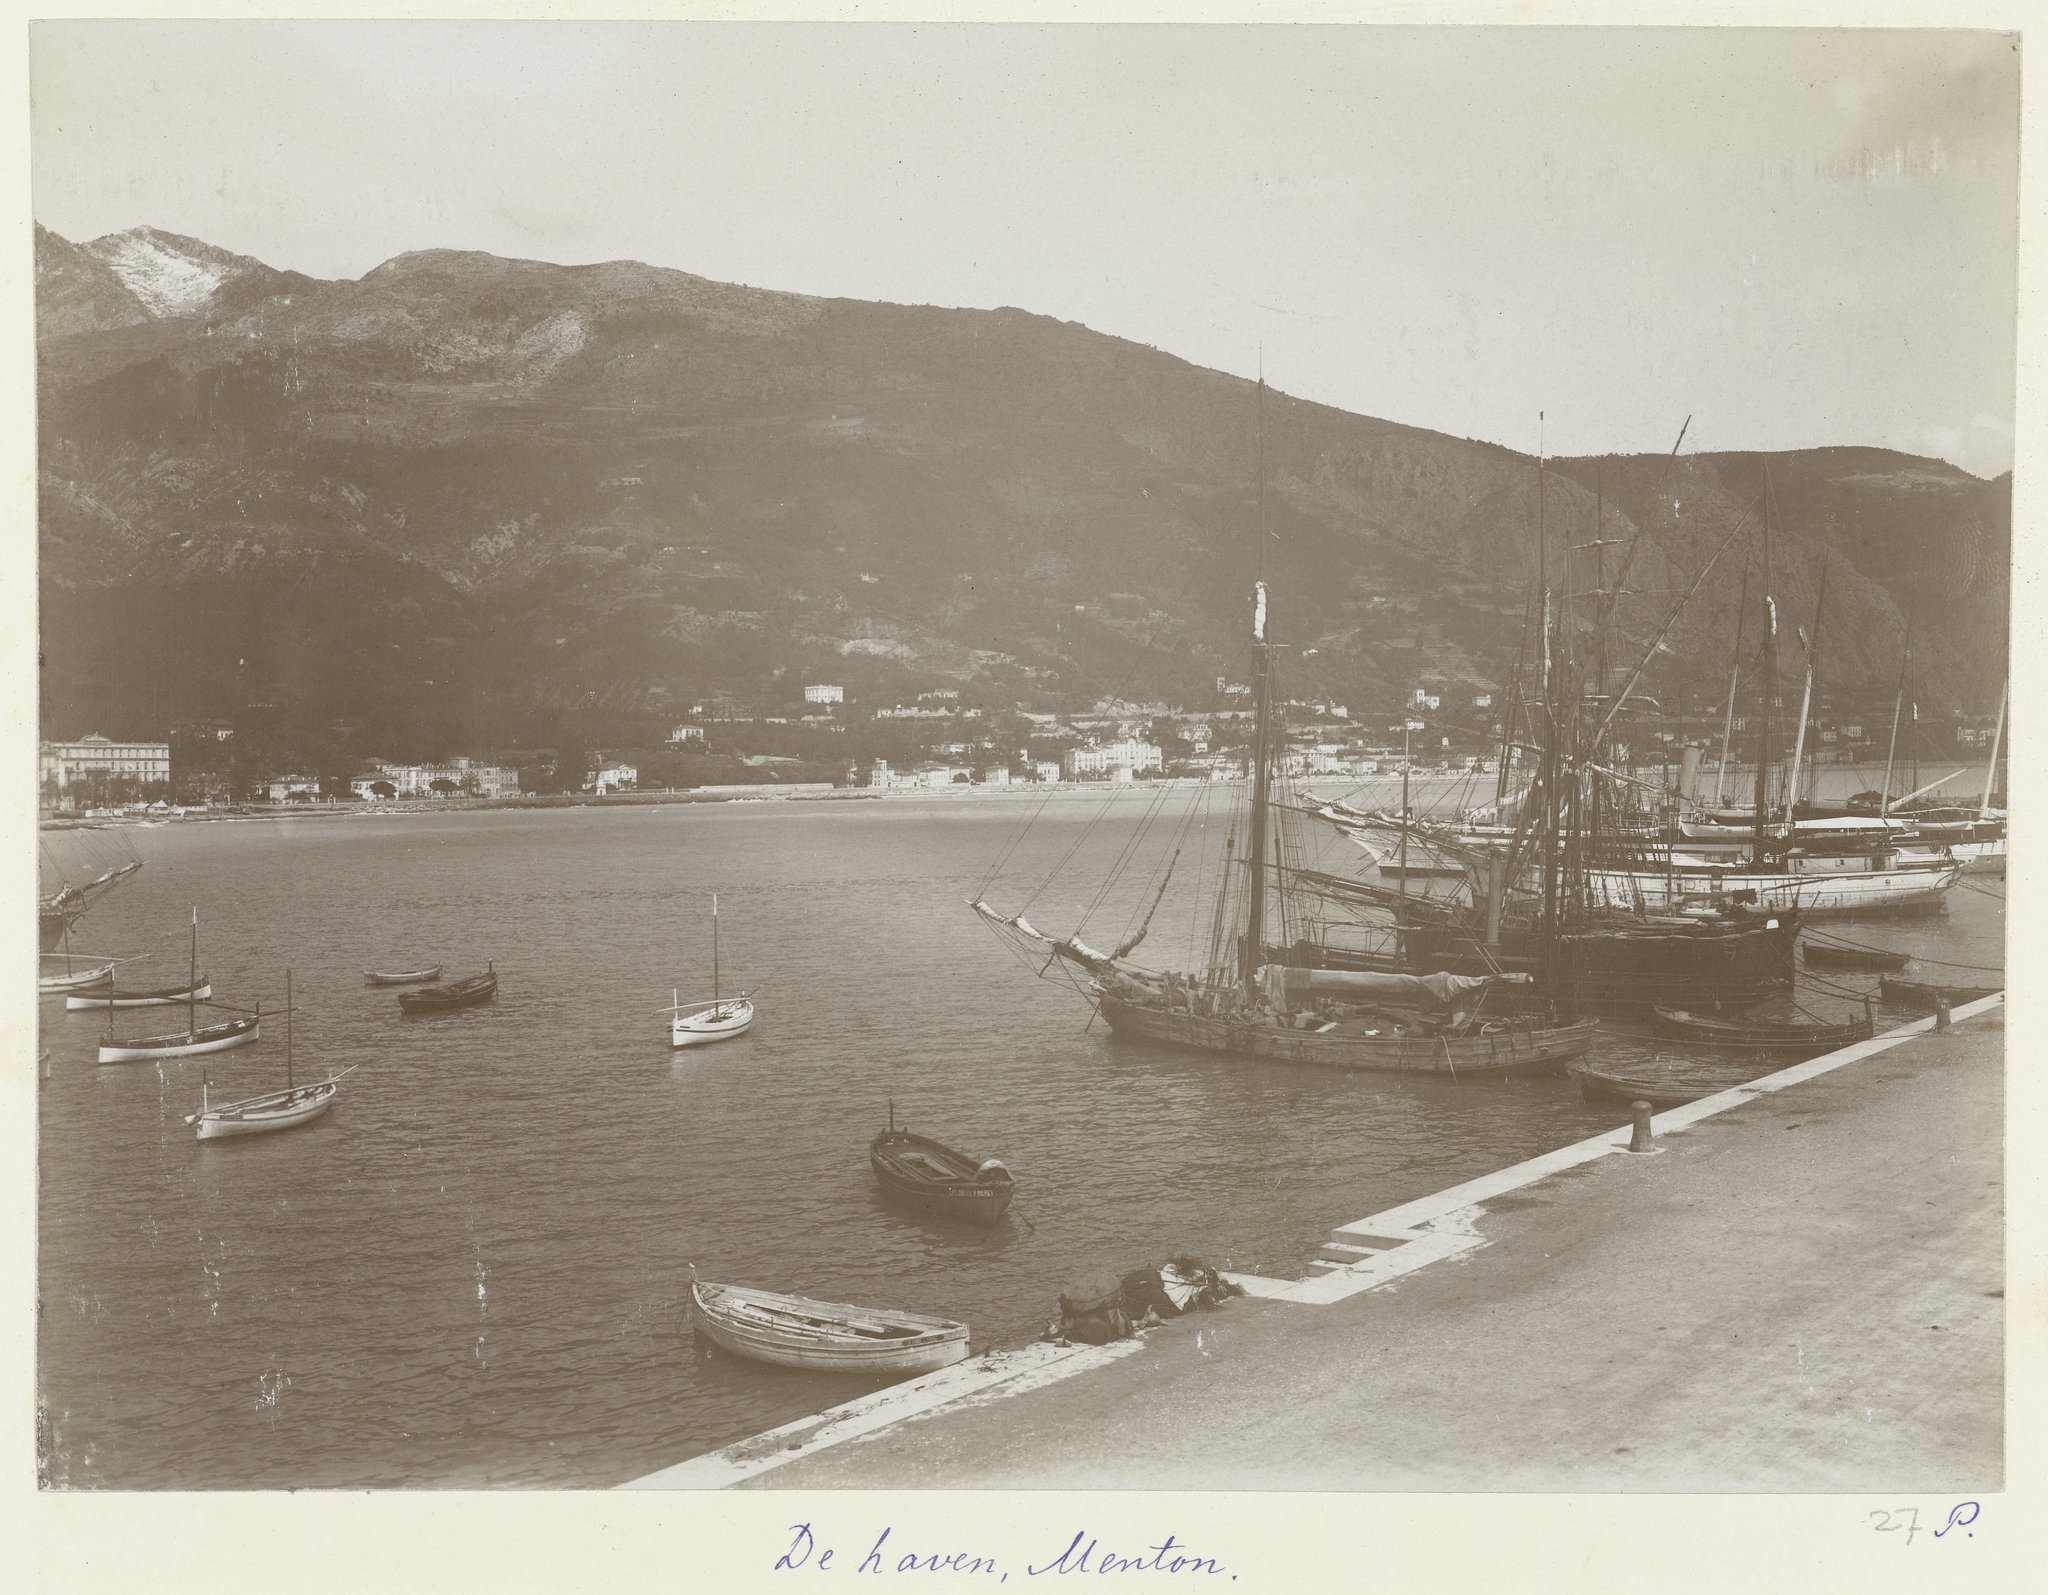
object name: photograph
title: De haven, Menton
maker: henry pauw van wieldrecht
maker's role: fotograaf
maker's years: 1863-1912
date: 1886-1896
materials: cardboard, photographic support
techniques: albumen print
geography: france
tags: menton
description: De Haven van Menton met aangemeerde zeilschepen in groot en klein formaat. Op de achtergrond het bergachtige landschap van de omgeving van Menton.